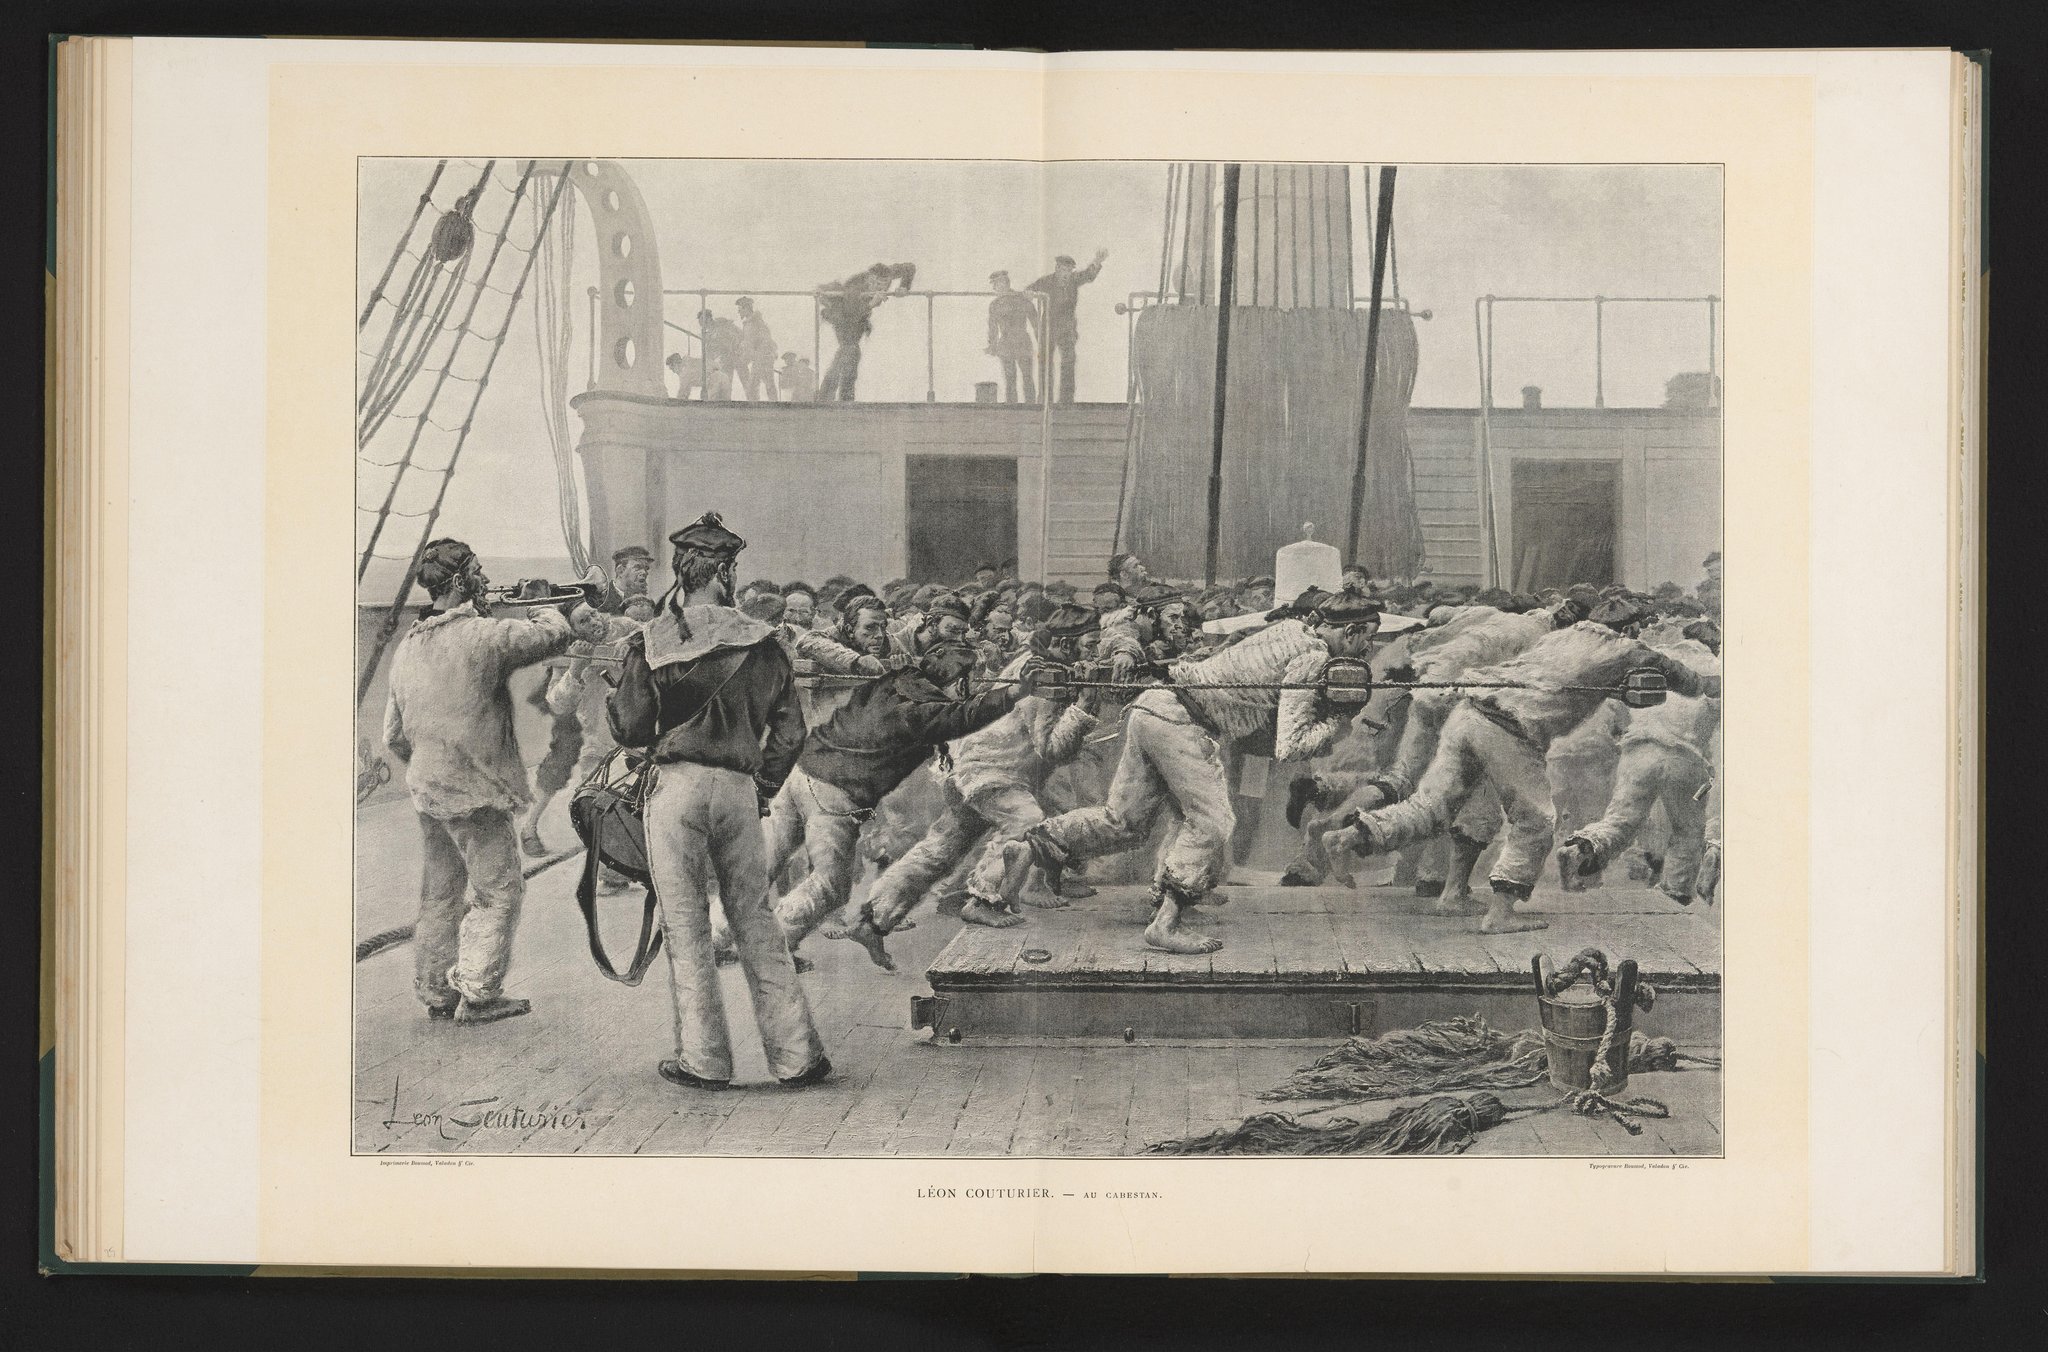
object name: photomechanical print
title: Au cabestan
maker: Anonymous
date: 1885-1901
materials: paper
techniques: autotype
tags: crew ~ ship (+ view ~ vehicle, ship, etc.)